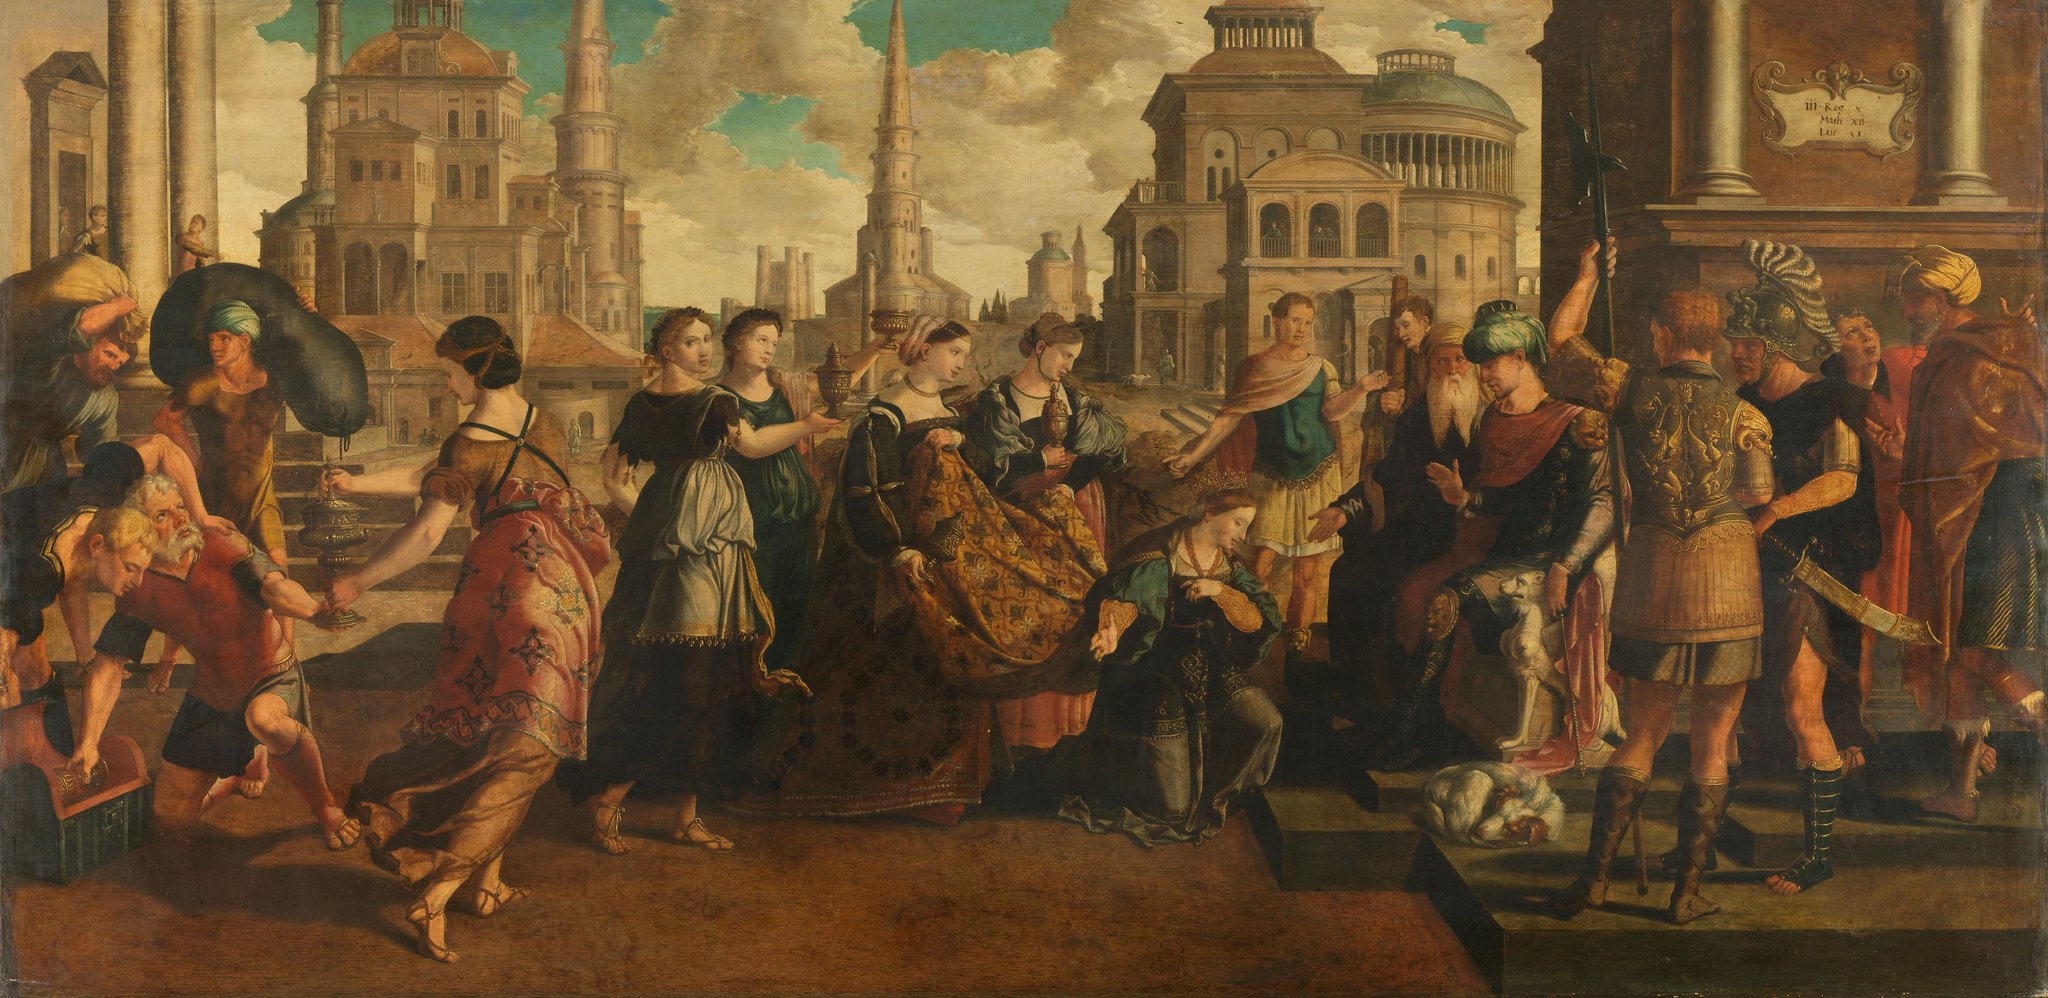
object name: painting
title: Solomon and the Queen of Sheba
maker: jan van scorel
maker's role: draughtsman, painter, print maker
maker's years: 1495-1562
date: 1540-1545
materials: oil, panel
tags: homage to solomon: the queen of sheba gives solomon gold, precious stones and spices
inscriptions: inscription, upper right, on the cartouche: ‘iii . Reg . X // Matth . XII // Luc . XI’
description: Salomo en de koningin van Sheba. De koningin van Sheba, begeleid door hofdames met geschenken, knielt neer voor Salomo die rechts op zijn troon zit. Op de achtergrond gebouwen en torens van de stad Jerusalem. Bij Salomo staan lijfwachten en raadgevers, aan zijn voeten slaapt een hond.